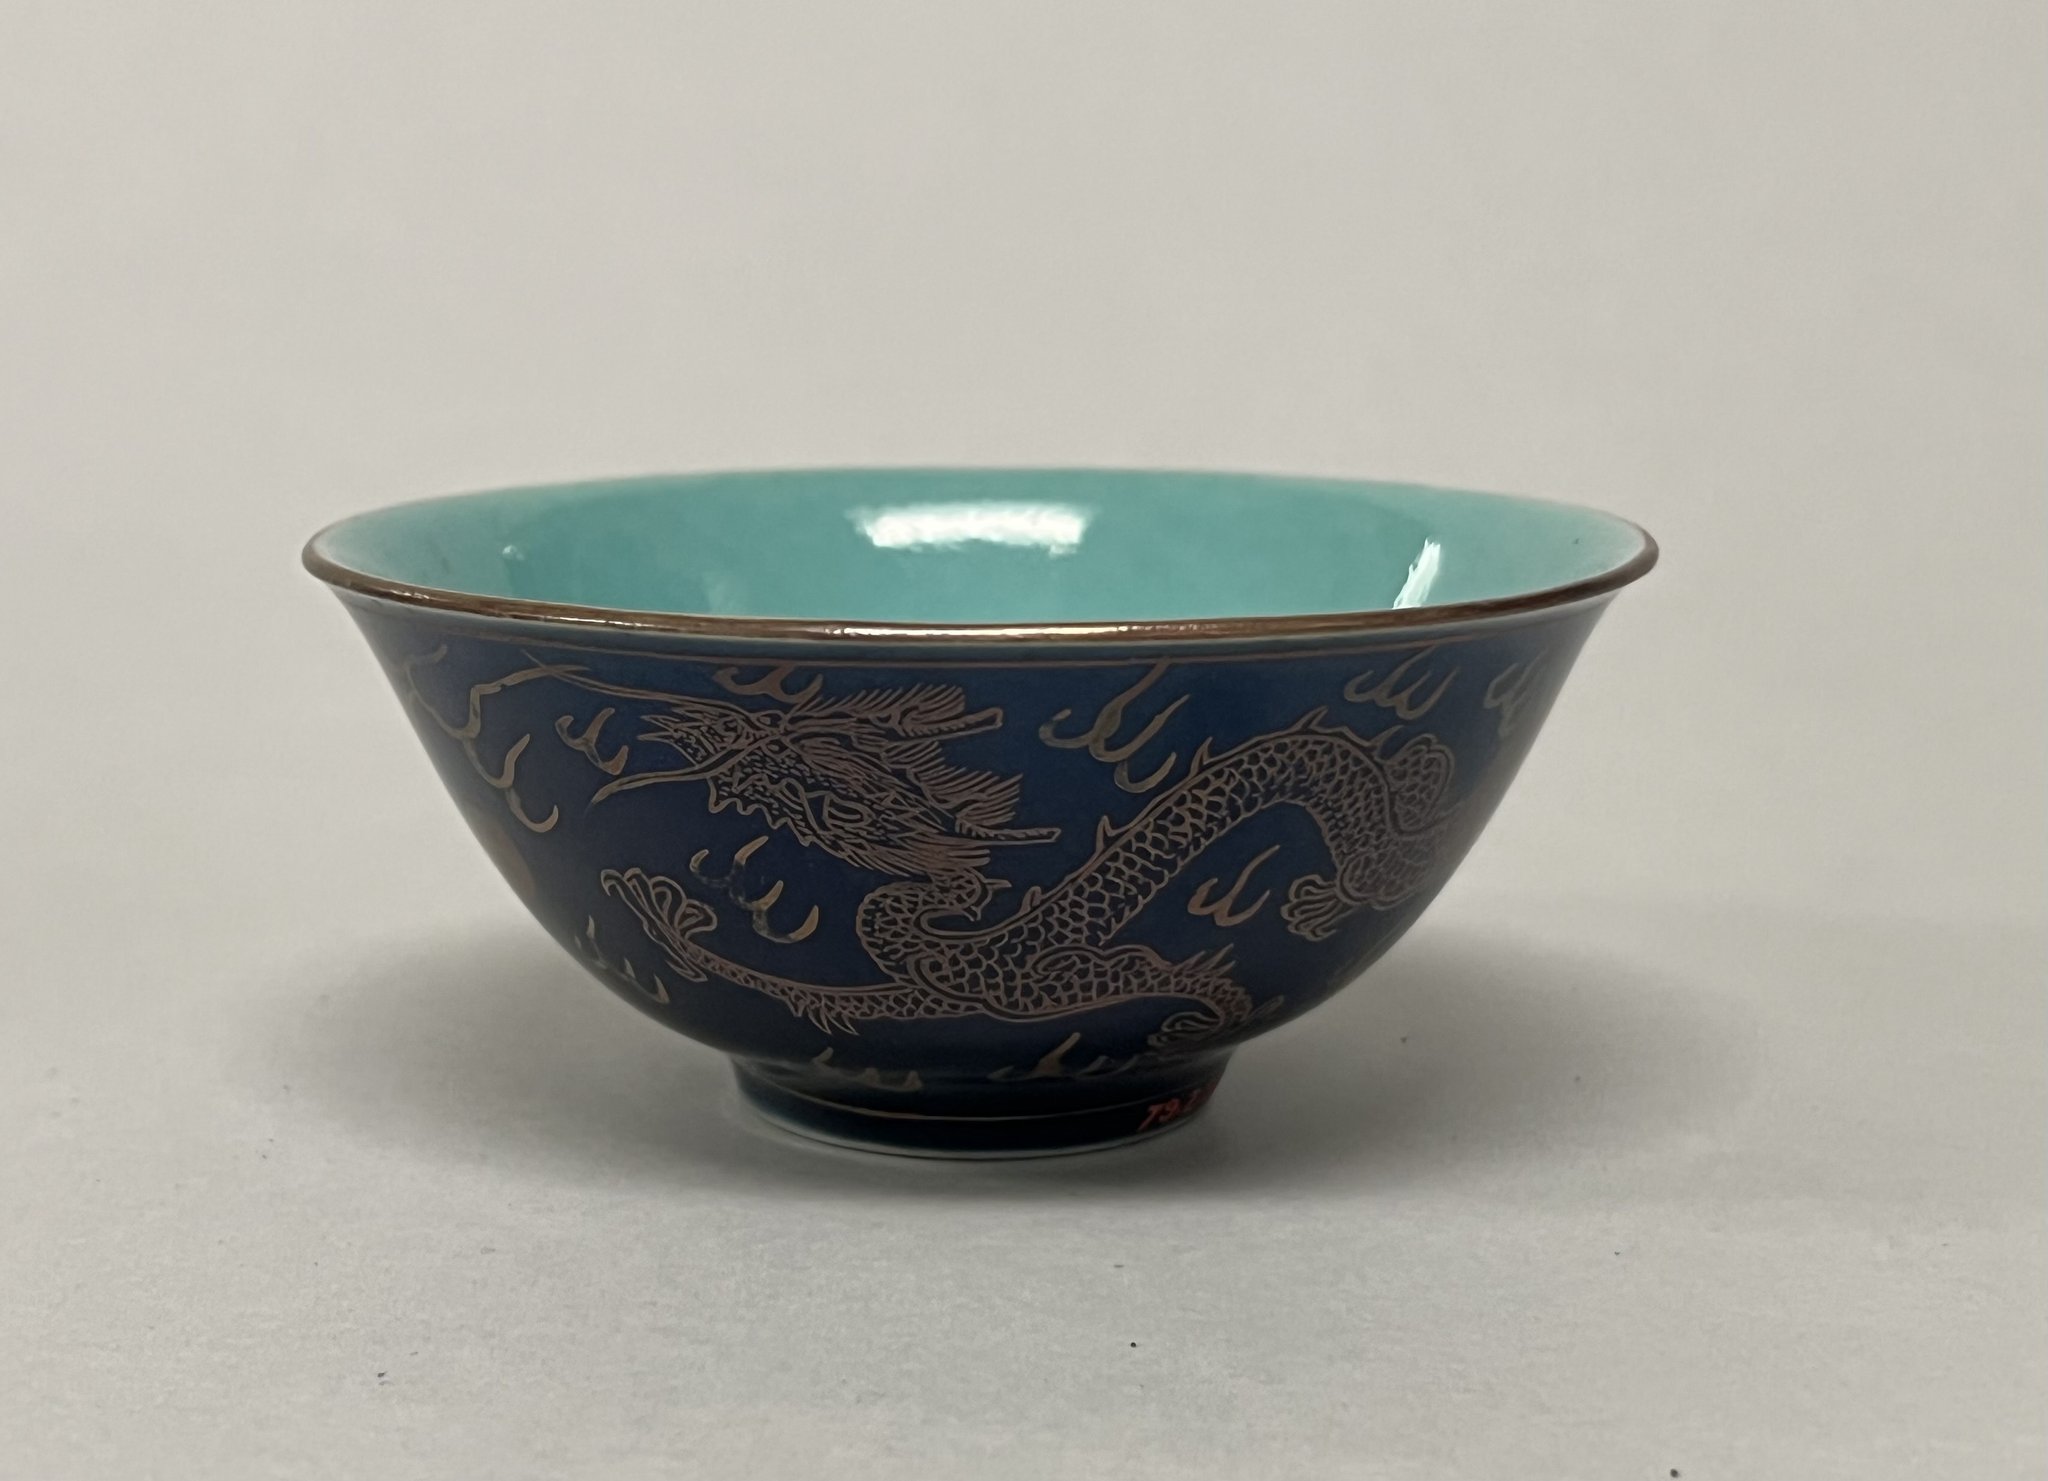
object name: bowl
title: Bowl with dragon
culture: chinese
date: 1767-1800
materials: gilt, glaze, porcelain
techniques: painting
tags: dragons